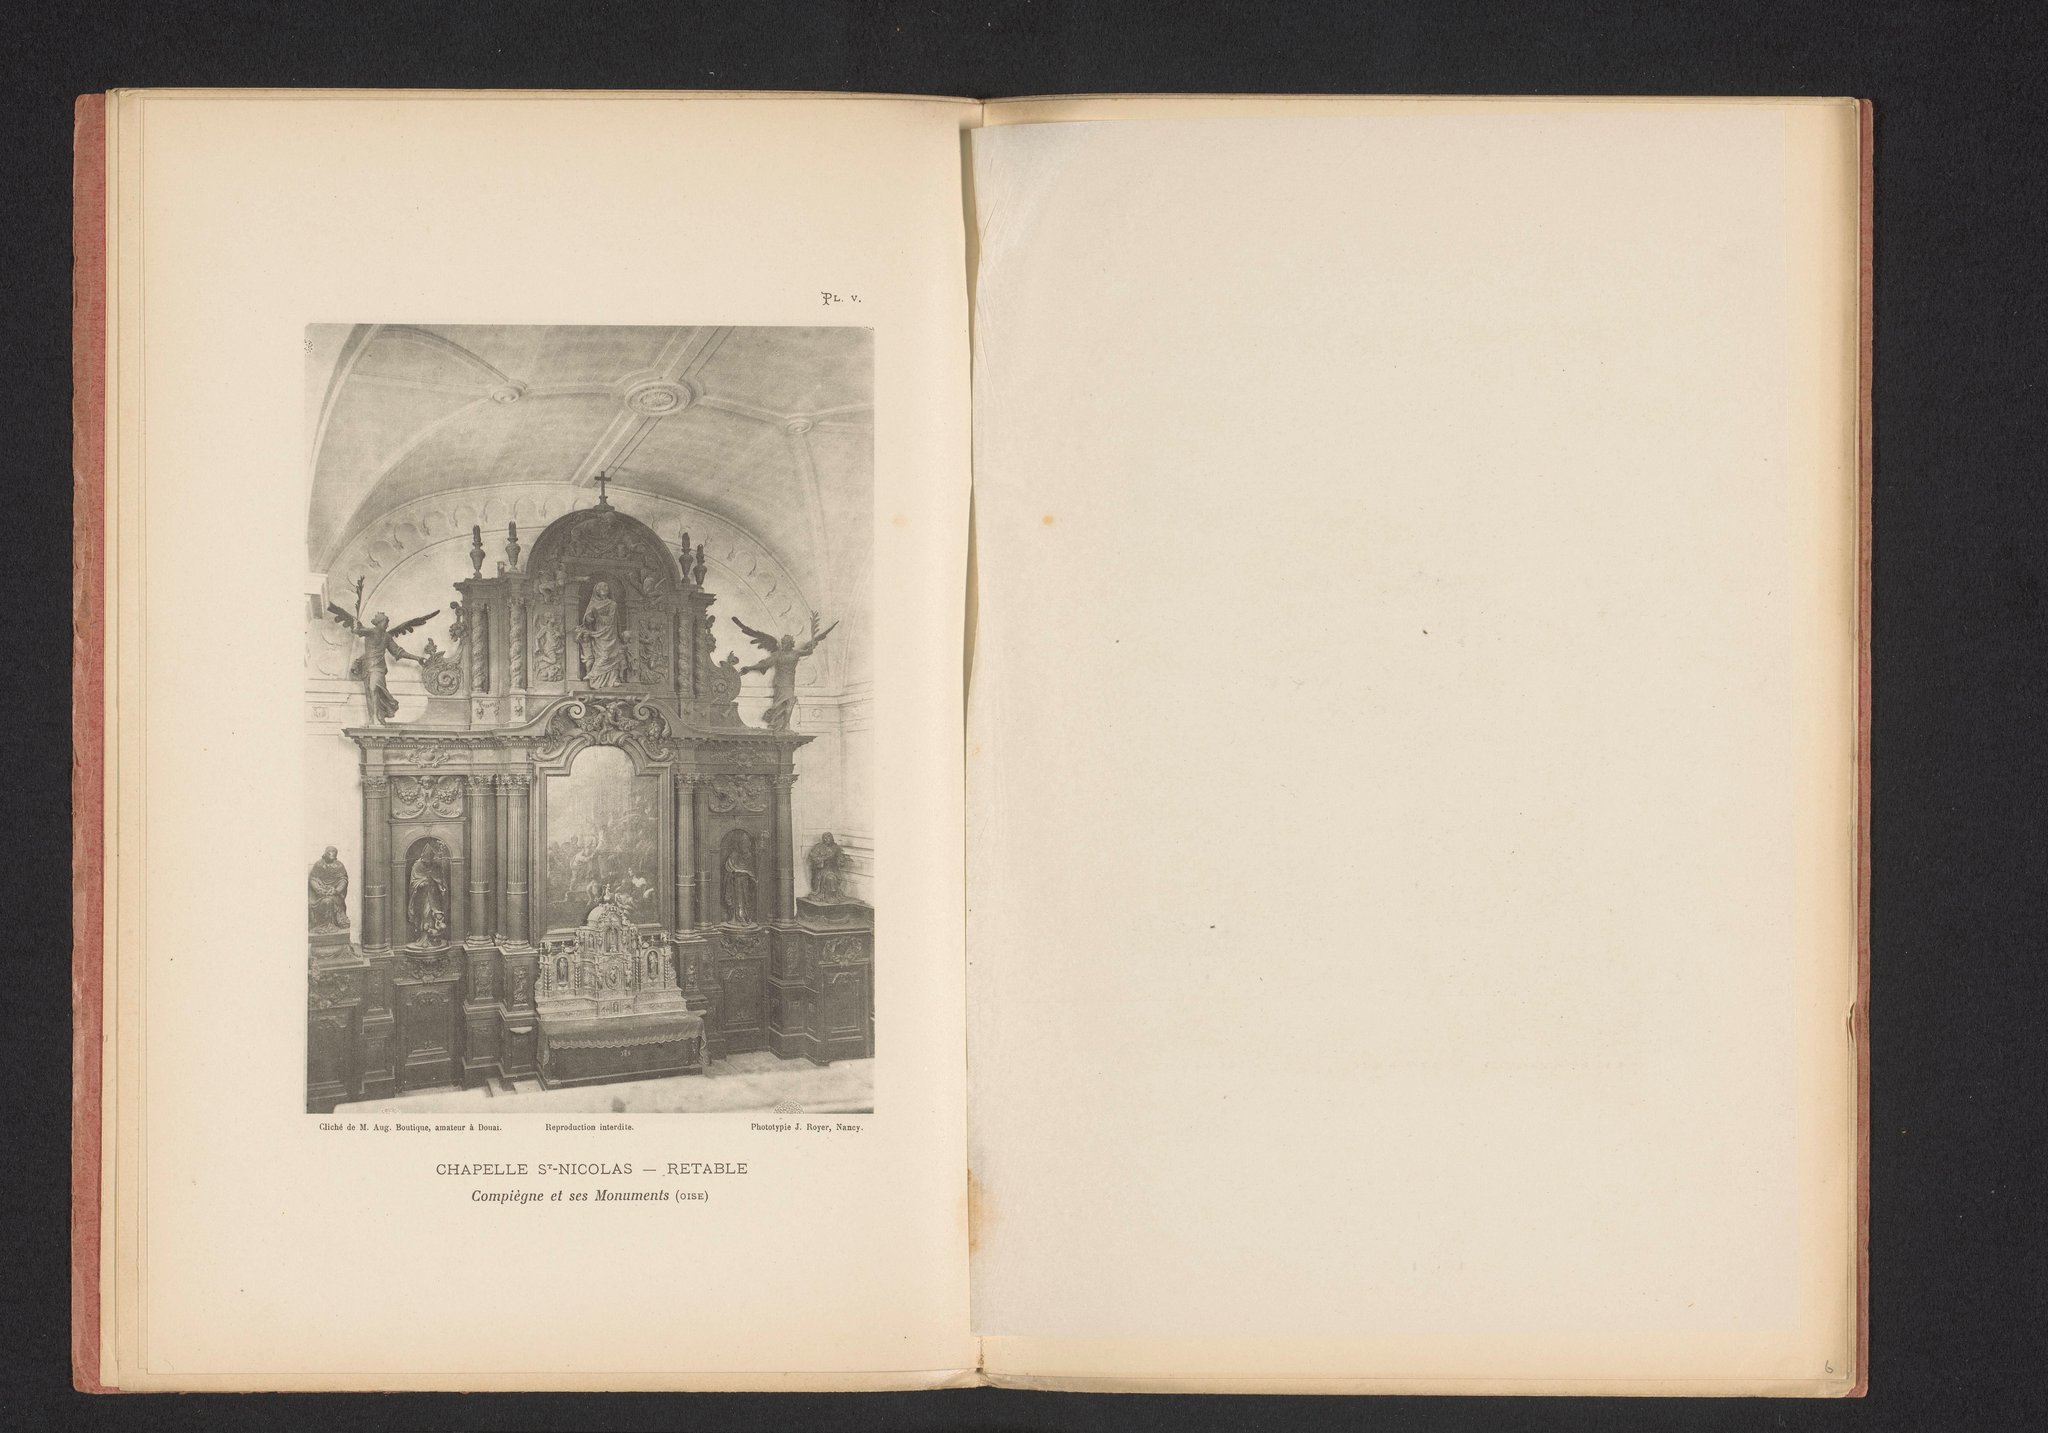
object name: page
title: Chapelle St-Nicolas - Retable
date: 1890-1895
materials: paper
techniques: photograph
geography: douai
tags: altar with altar-piece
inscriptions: number: ‘Pl. V.’, inscription: ‘Reproduction interdite.’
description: Prent op vierde ongenummerde pagina na pagina 4.